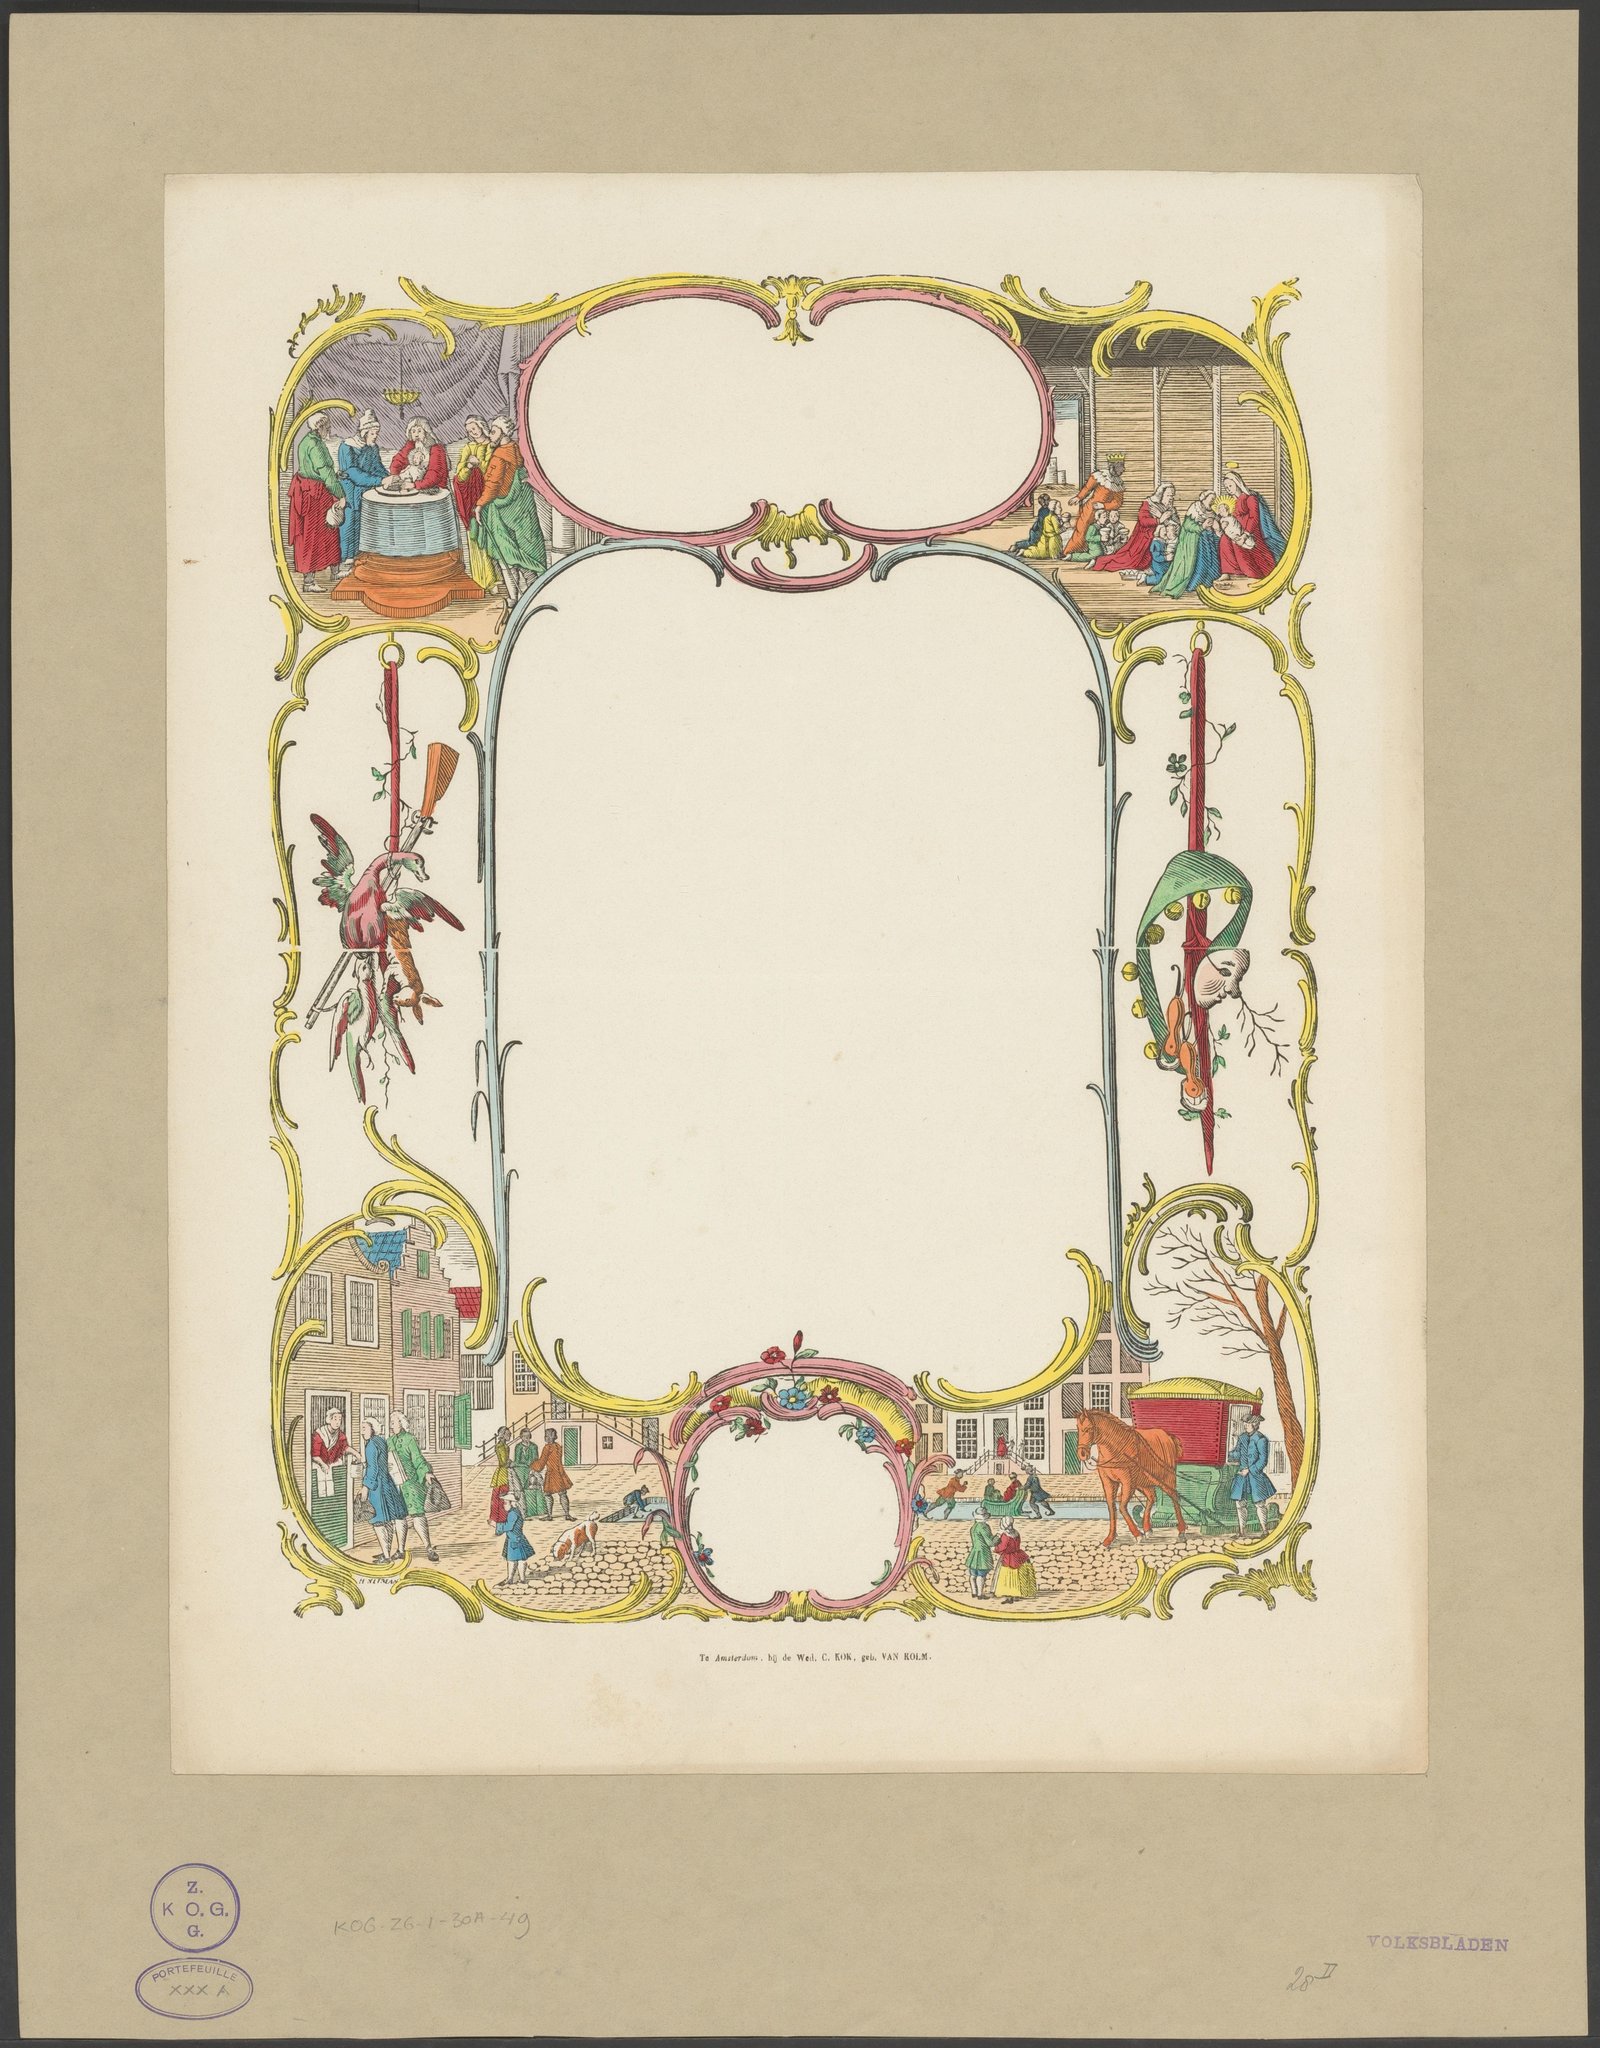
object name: print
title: Blanco wensbrief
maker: weduwe c. kok geboren van kolm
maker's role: printer, publisher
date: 1842-1866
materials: paper, watercolor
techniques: hand coloring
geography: amsterdam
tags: birth and youth of christ, public road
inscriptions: collector's mark, collector's mark: Lugt 1641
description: Blanco wensbrief. Onbeschreven cartouche op een voorgedrukt blad met een kader gevormd door boven scènes uit het verhaal van de geboorte van Christus en onder straattaferelen. Onderwerpsrubrieken binnen de Atlas Zeden en Gewoonten: Nieuwjaars- en kermiswenschen.